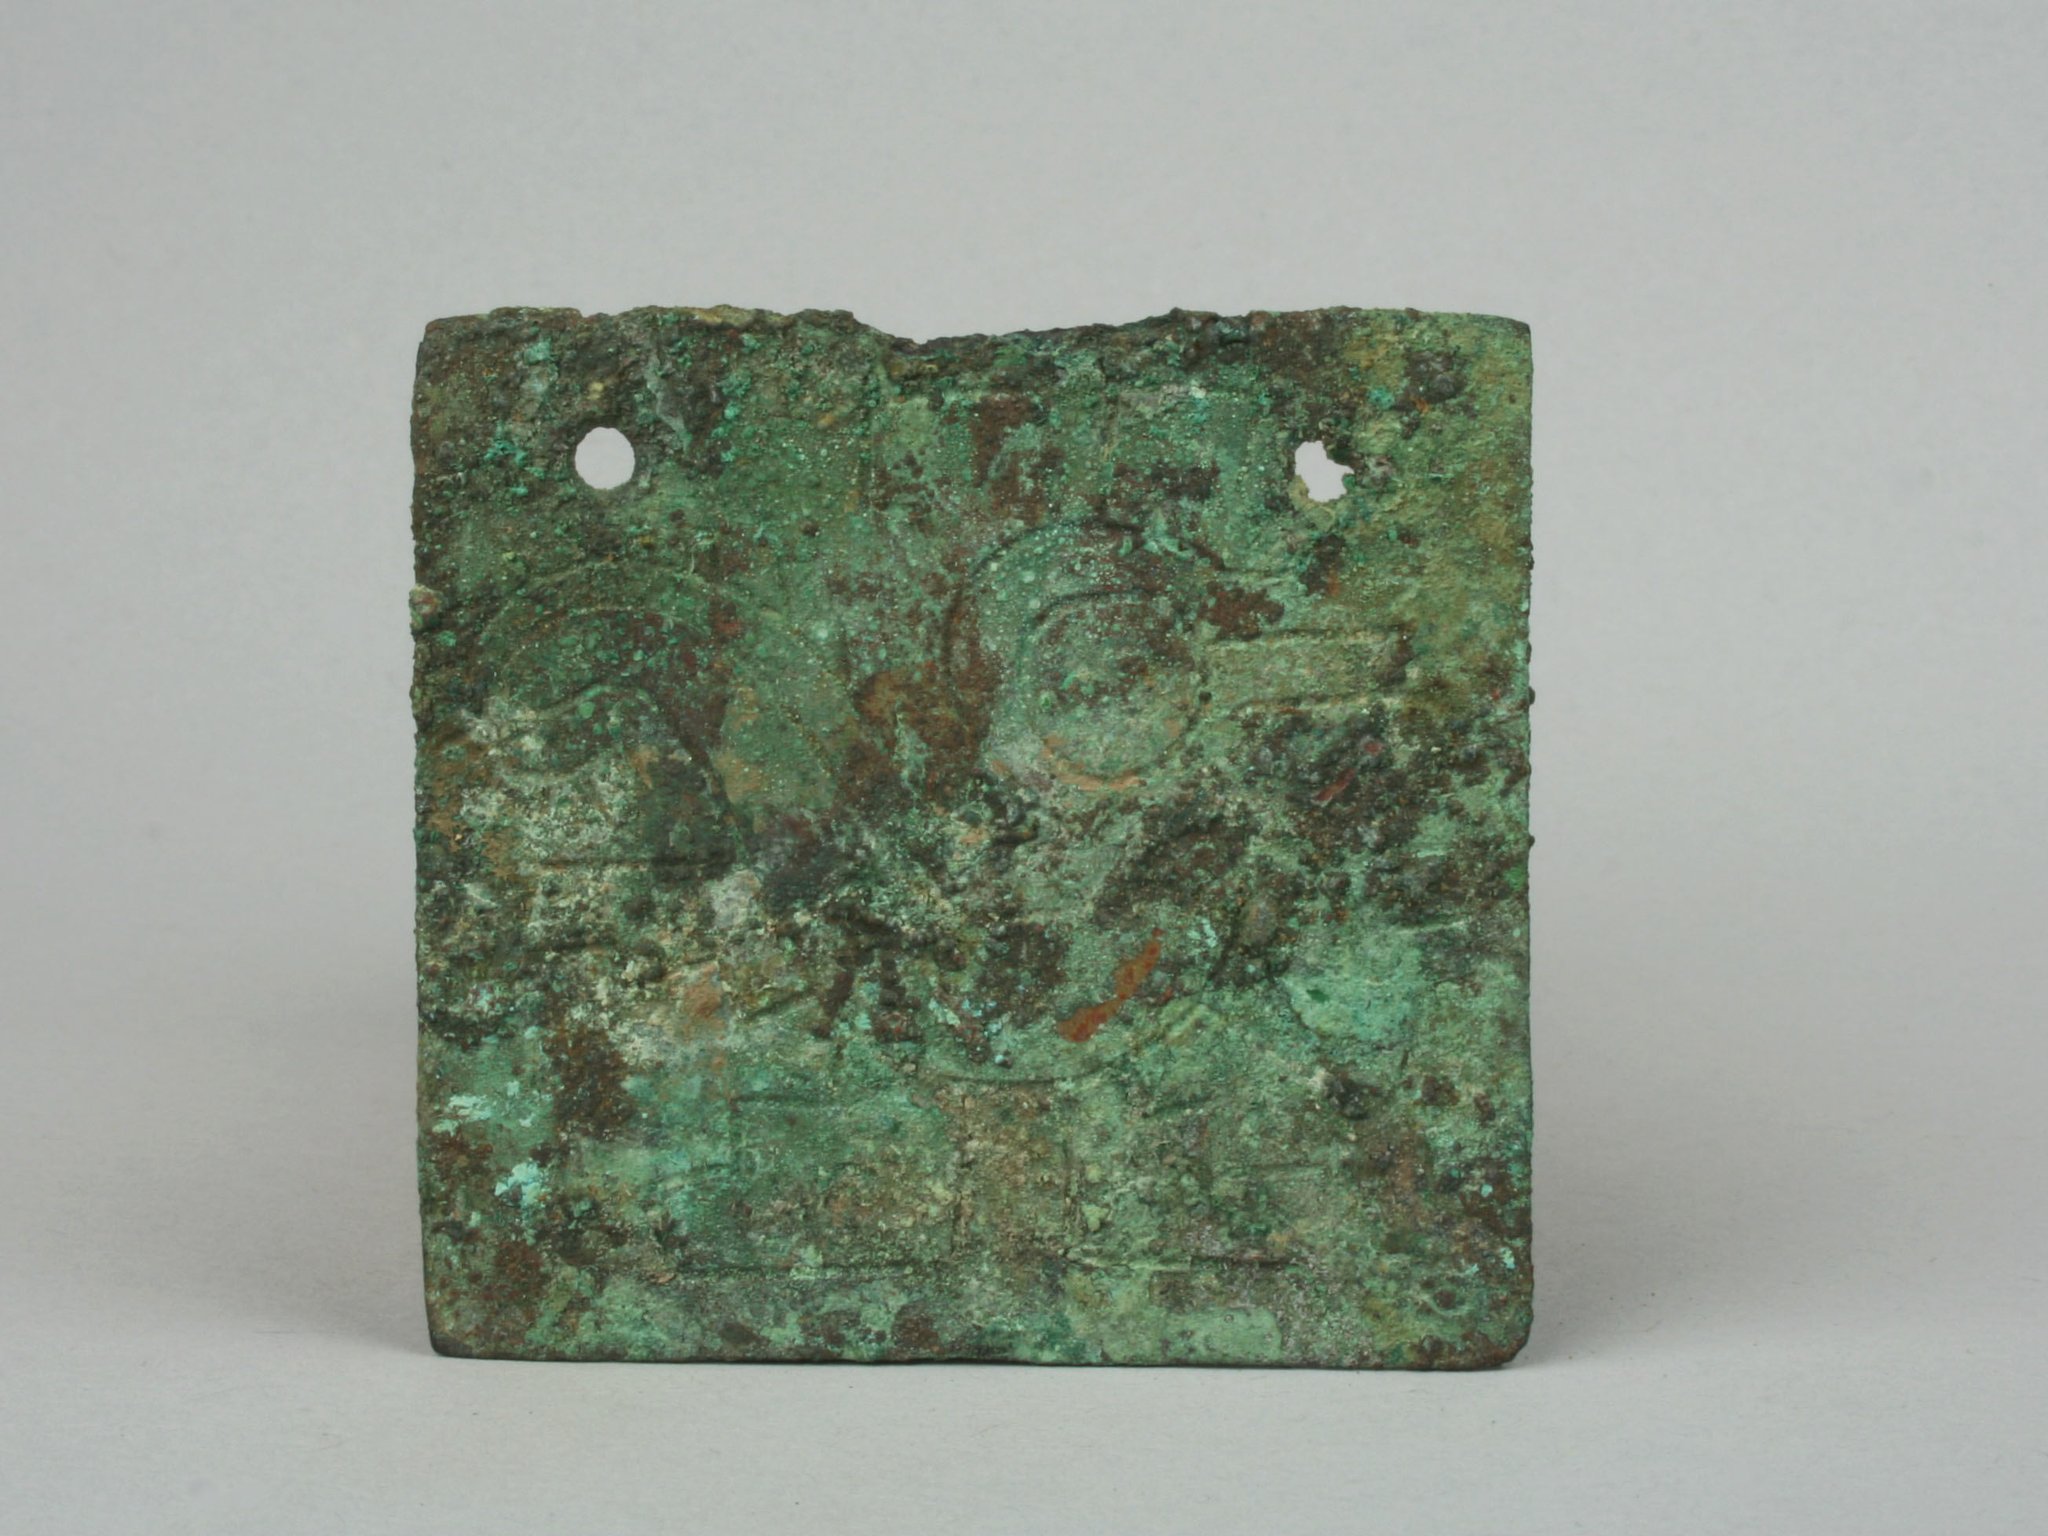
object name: ornament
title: Bird Plaque Ornament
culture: vicús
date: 300 BCE-200 CE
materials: copper, gilt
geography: peru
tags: birds